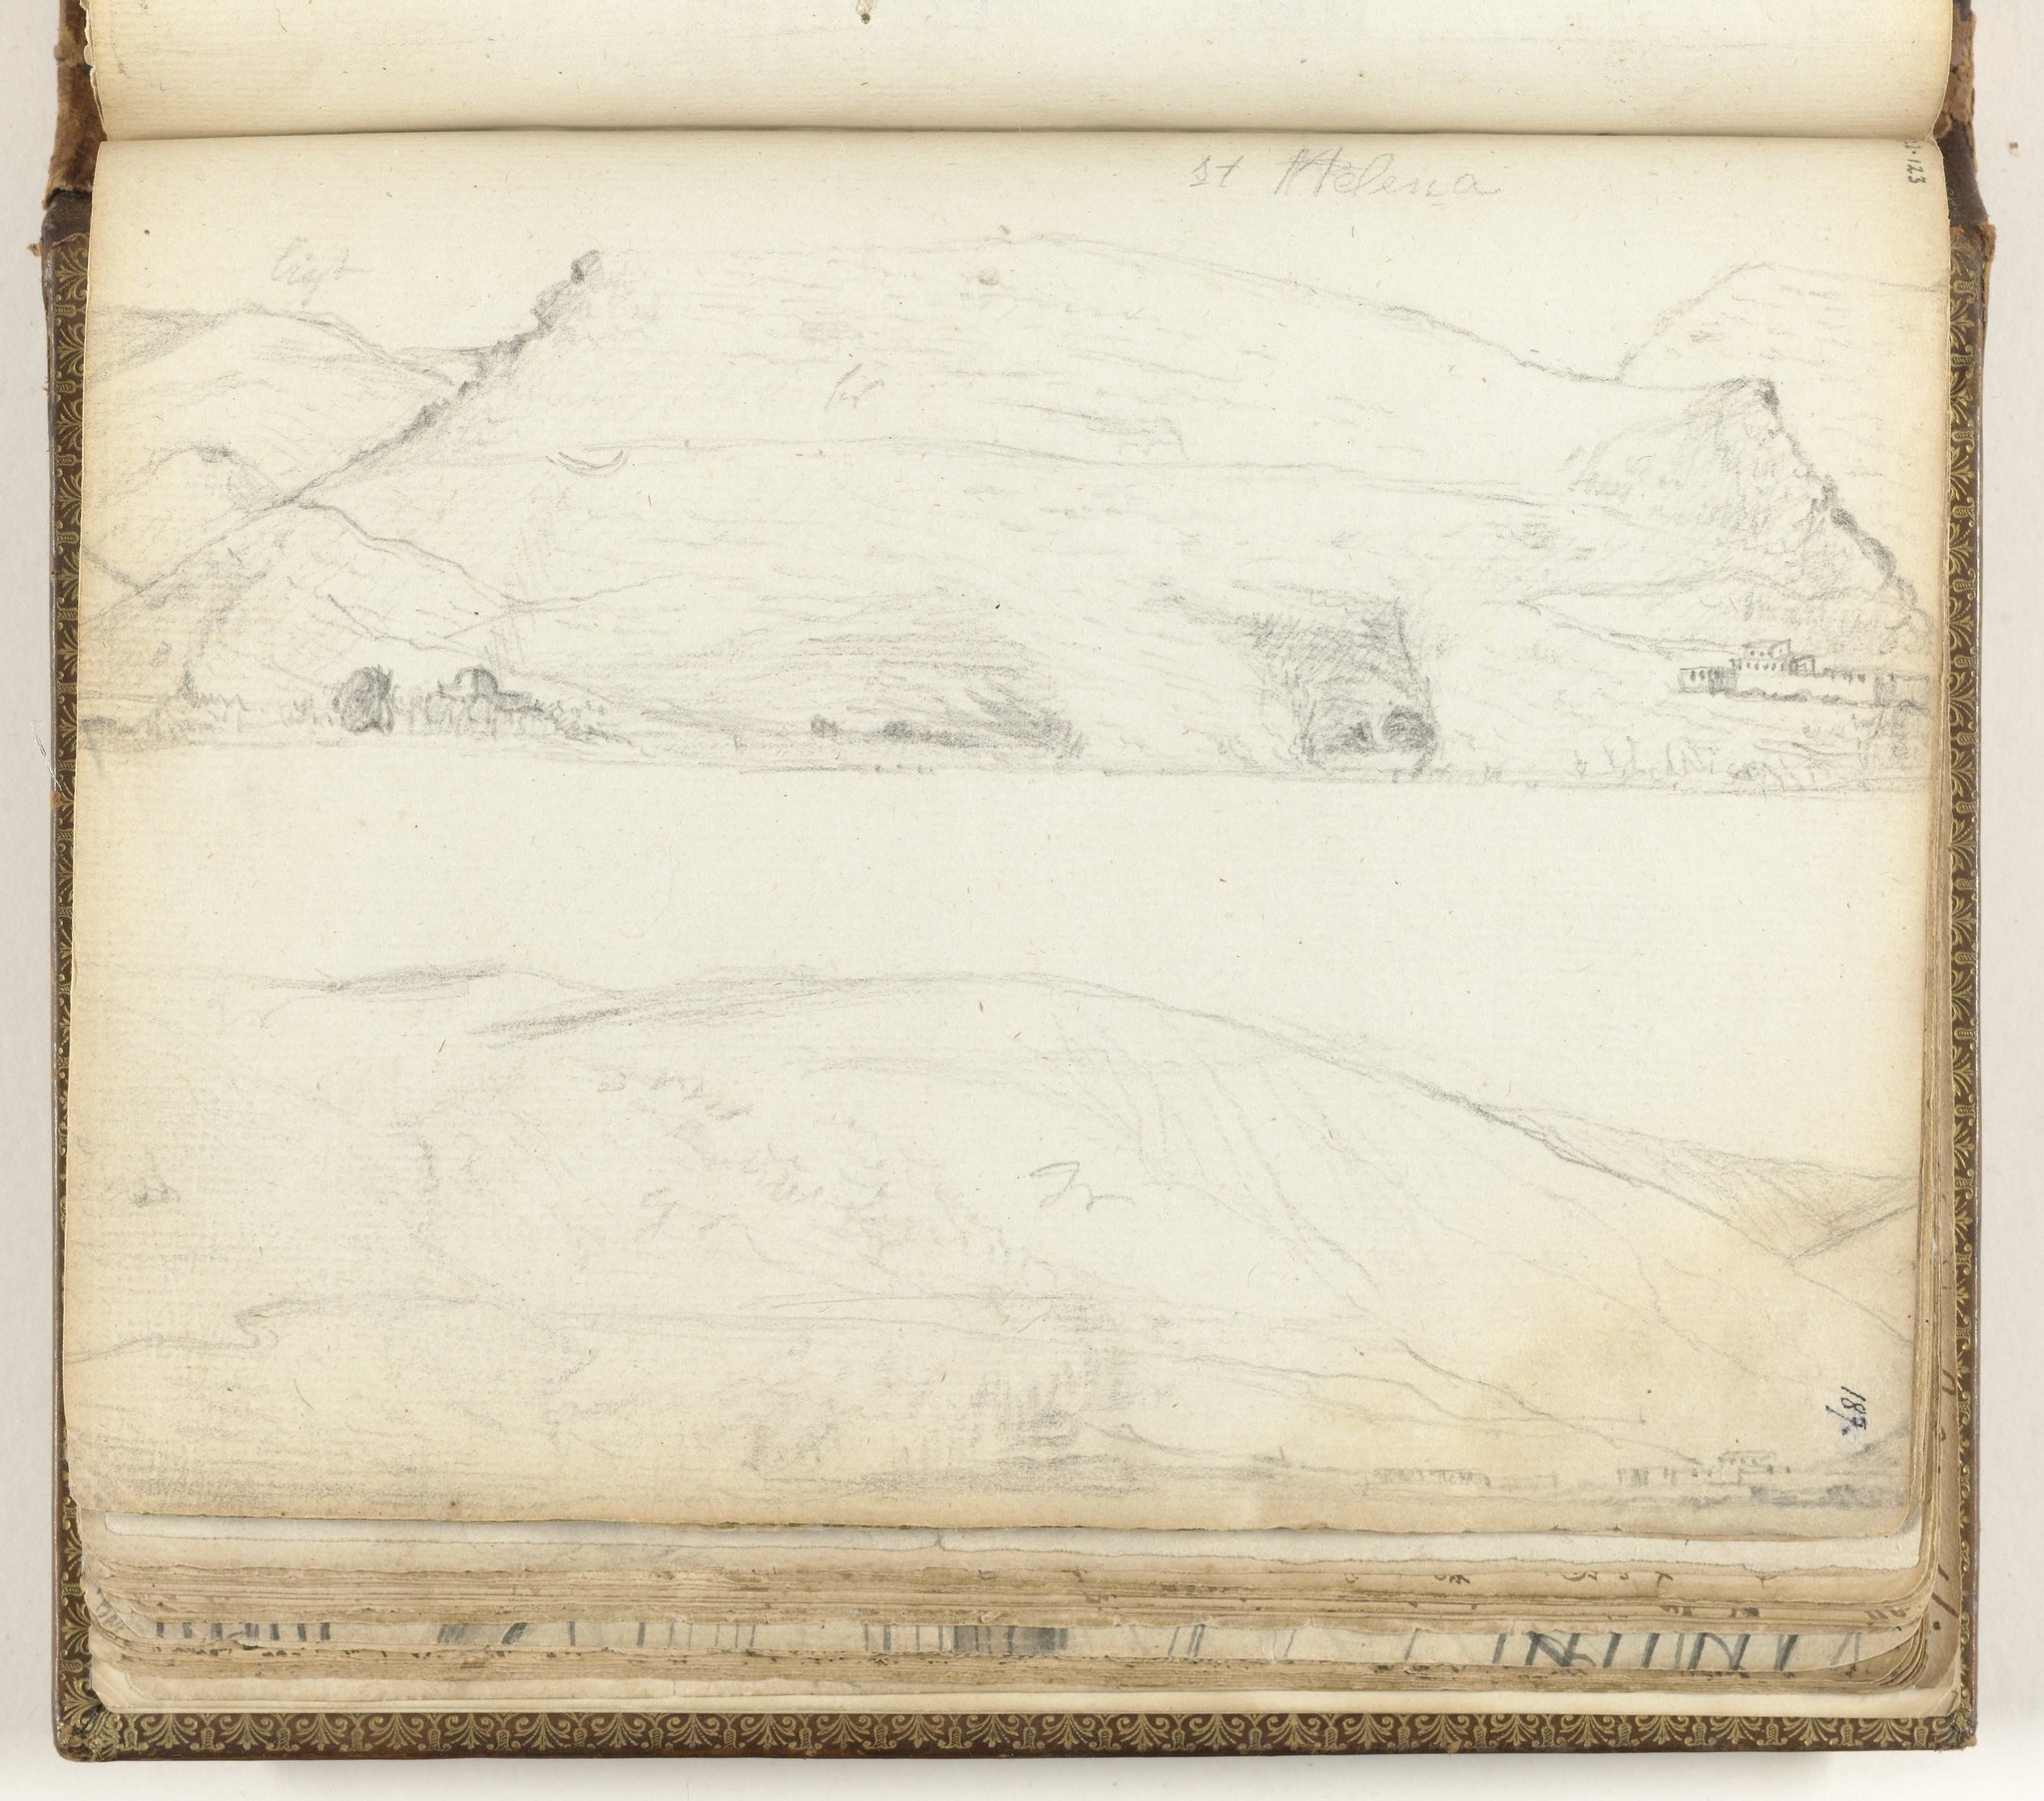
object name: drawing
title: Baai Sint-Helena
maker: jan brandes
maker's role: draughtsman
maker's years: 1743-1808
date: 1787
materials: paper, pencil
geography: sint-helena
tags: gulf, bay, rocky coast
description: Potloodschets van de baai van Sint-Helena. Met opschrift. Onderdeel uit het schetsboek van Jan Brandes, dl. 2 (1808), p. 186.